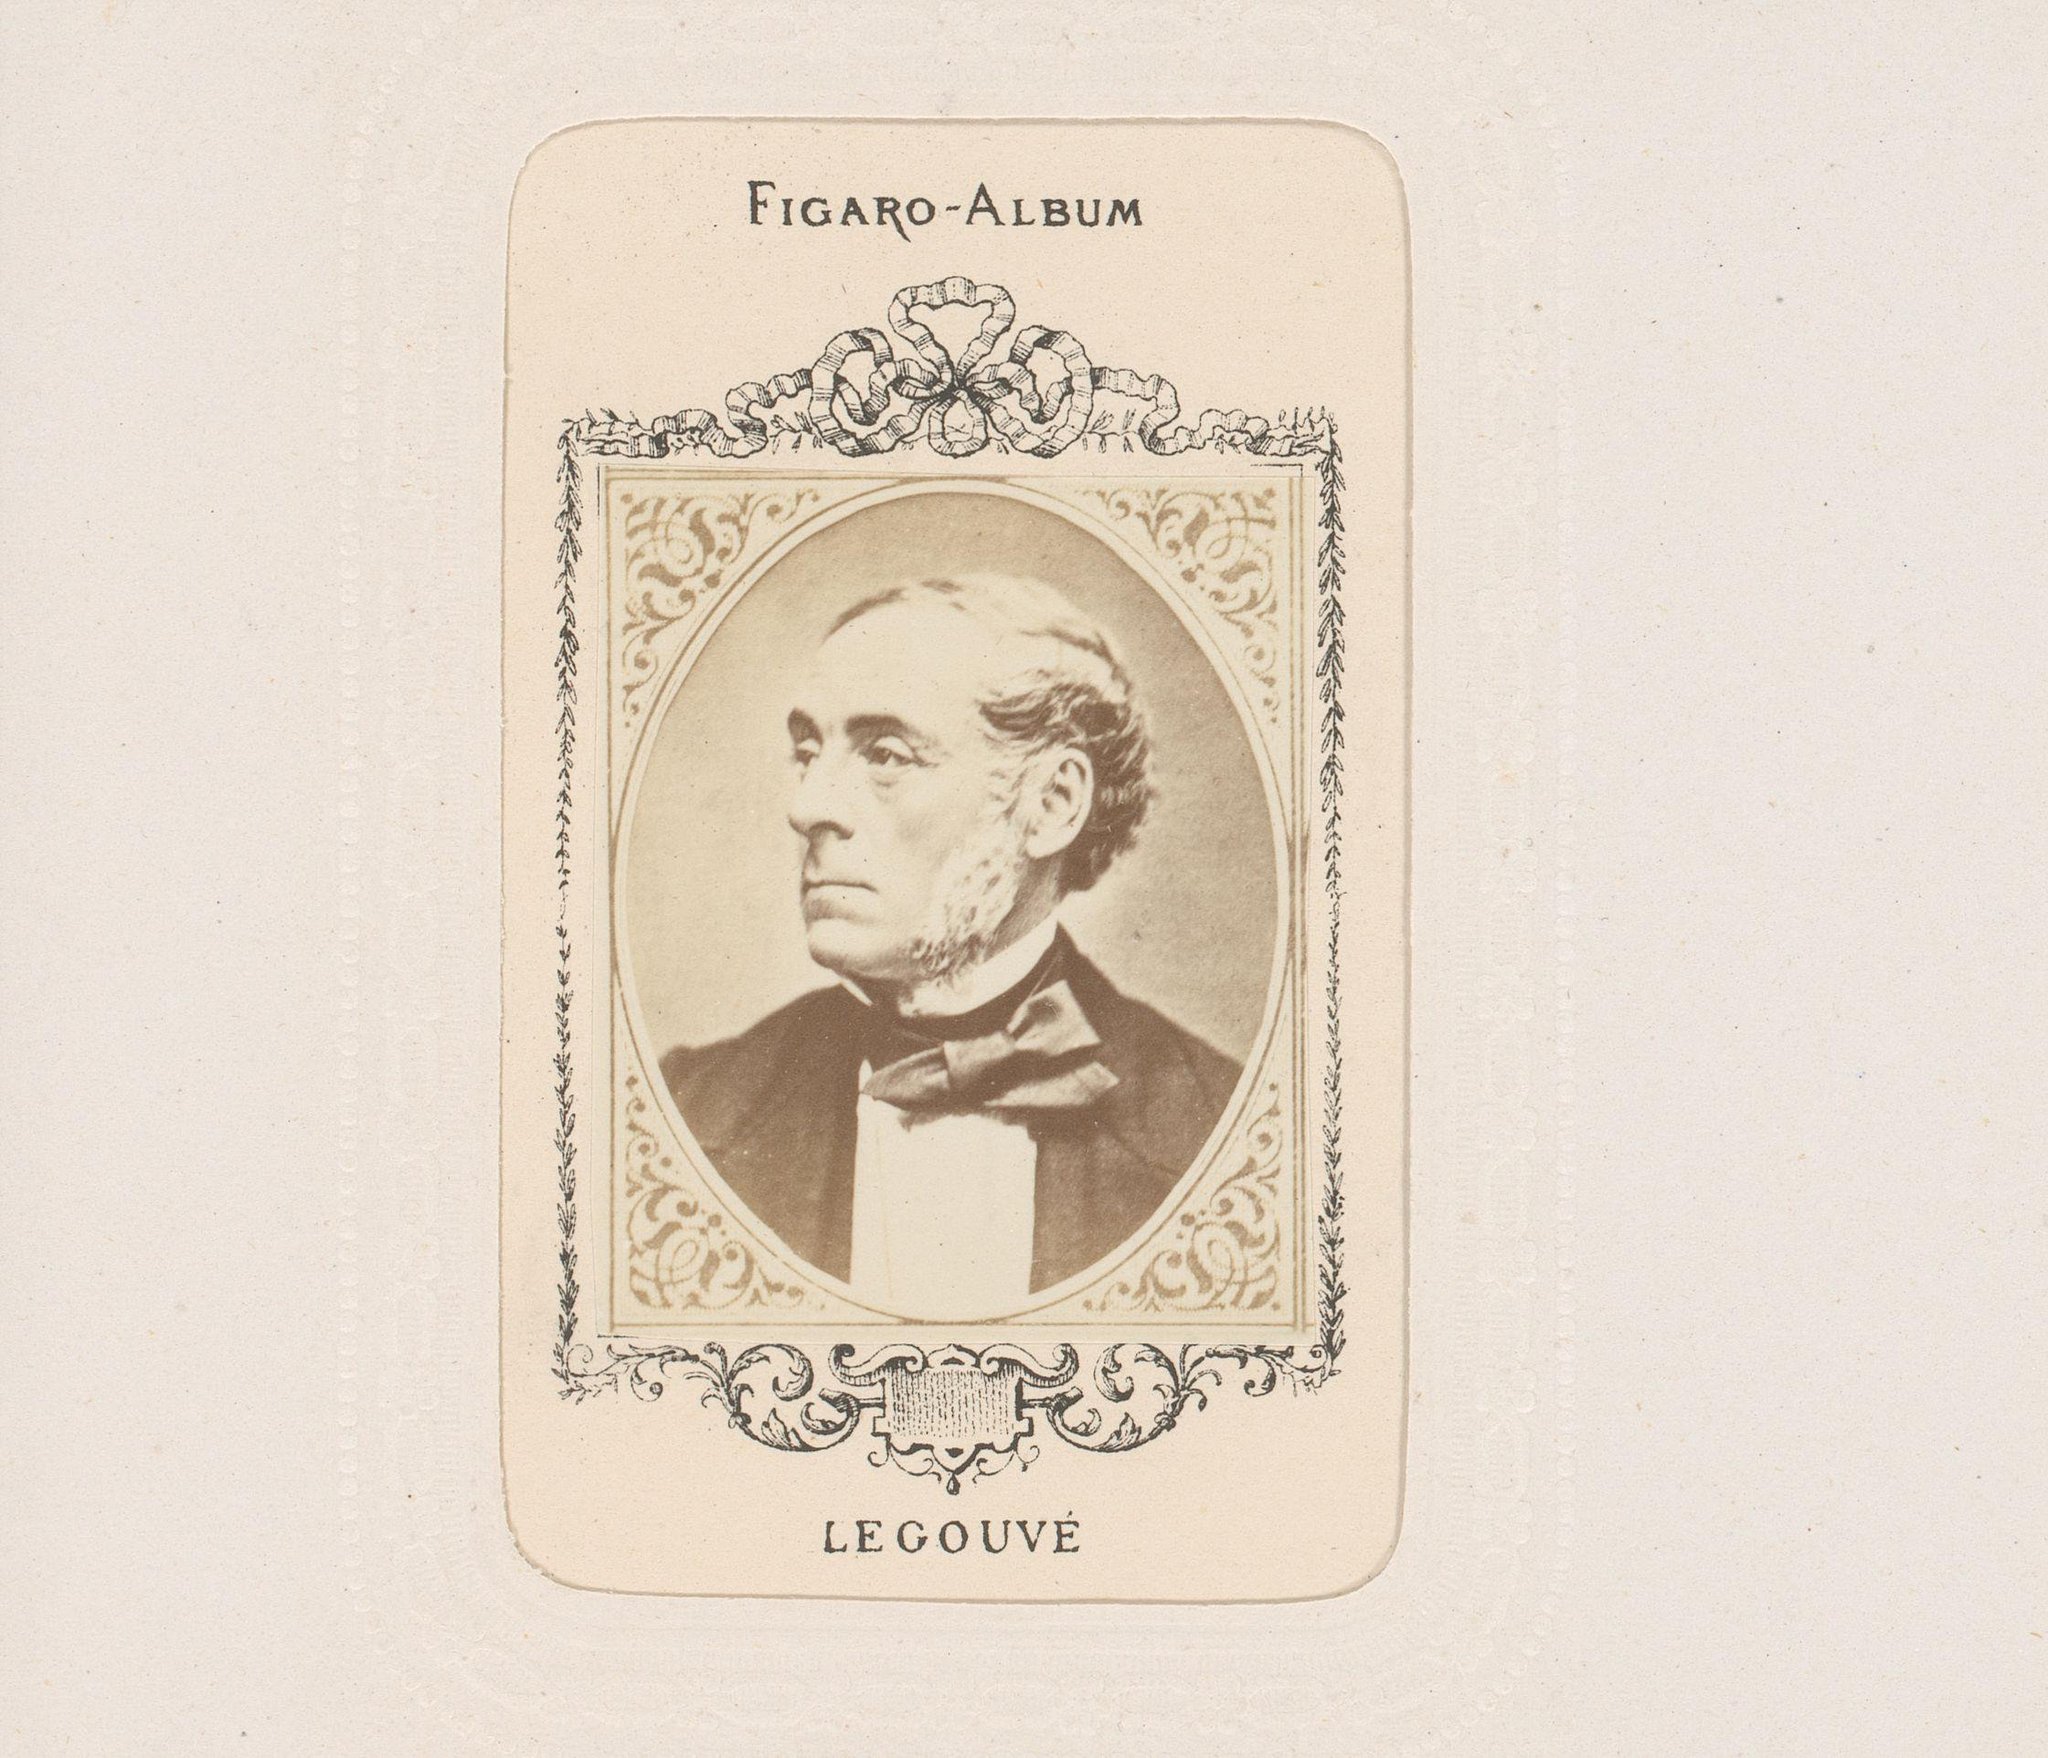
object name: photograph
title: Fotoreproductie van een portret van Ernest Legouvé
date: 1860-1900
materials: cardboard, photographic support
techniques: albumen print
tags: historical persons, portrait of a writer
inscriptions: inscription: ‘Figaro-Album/ Legouvé/ d'après Pierre Petit Phot.’